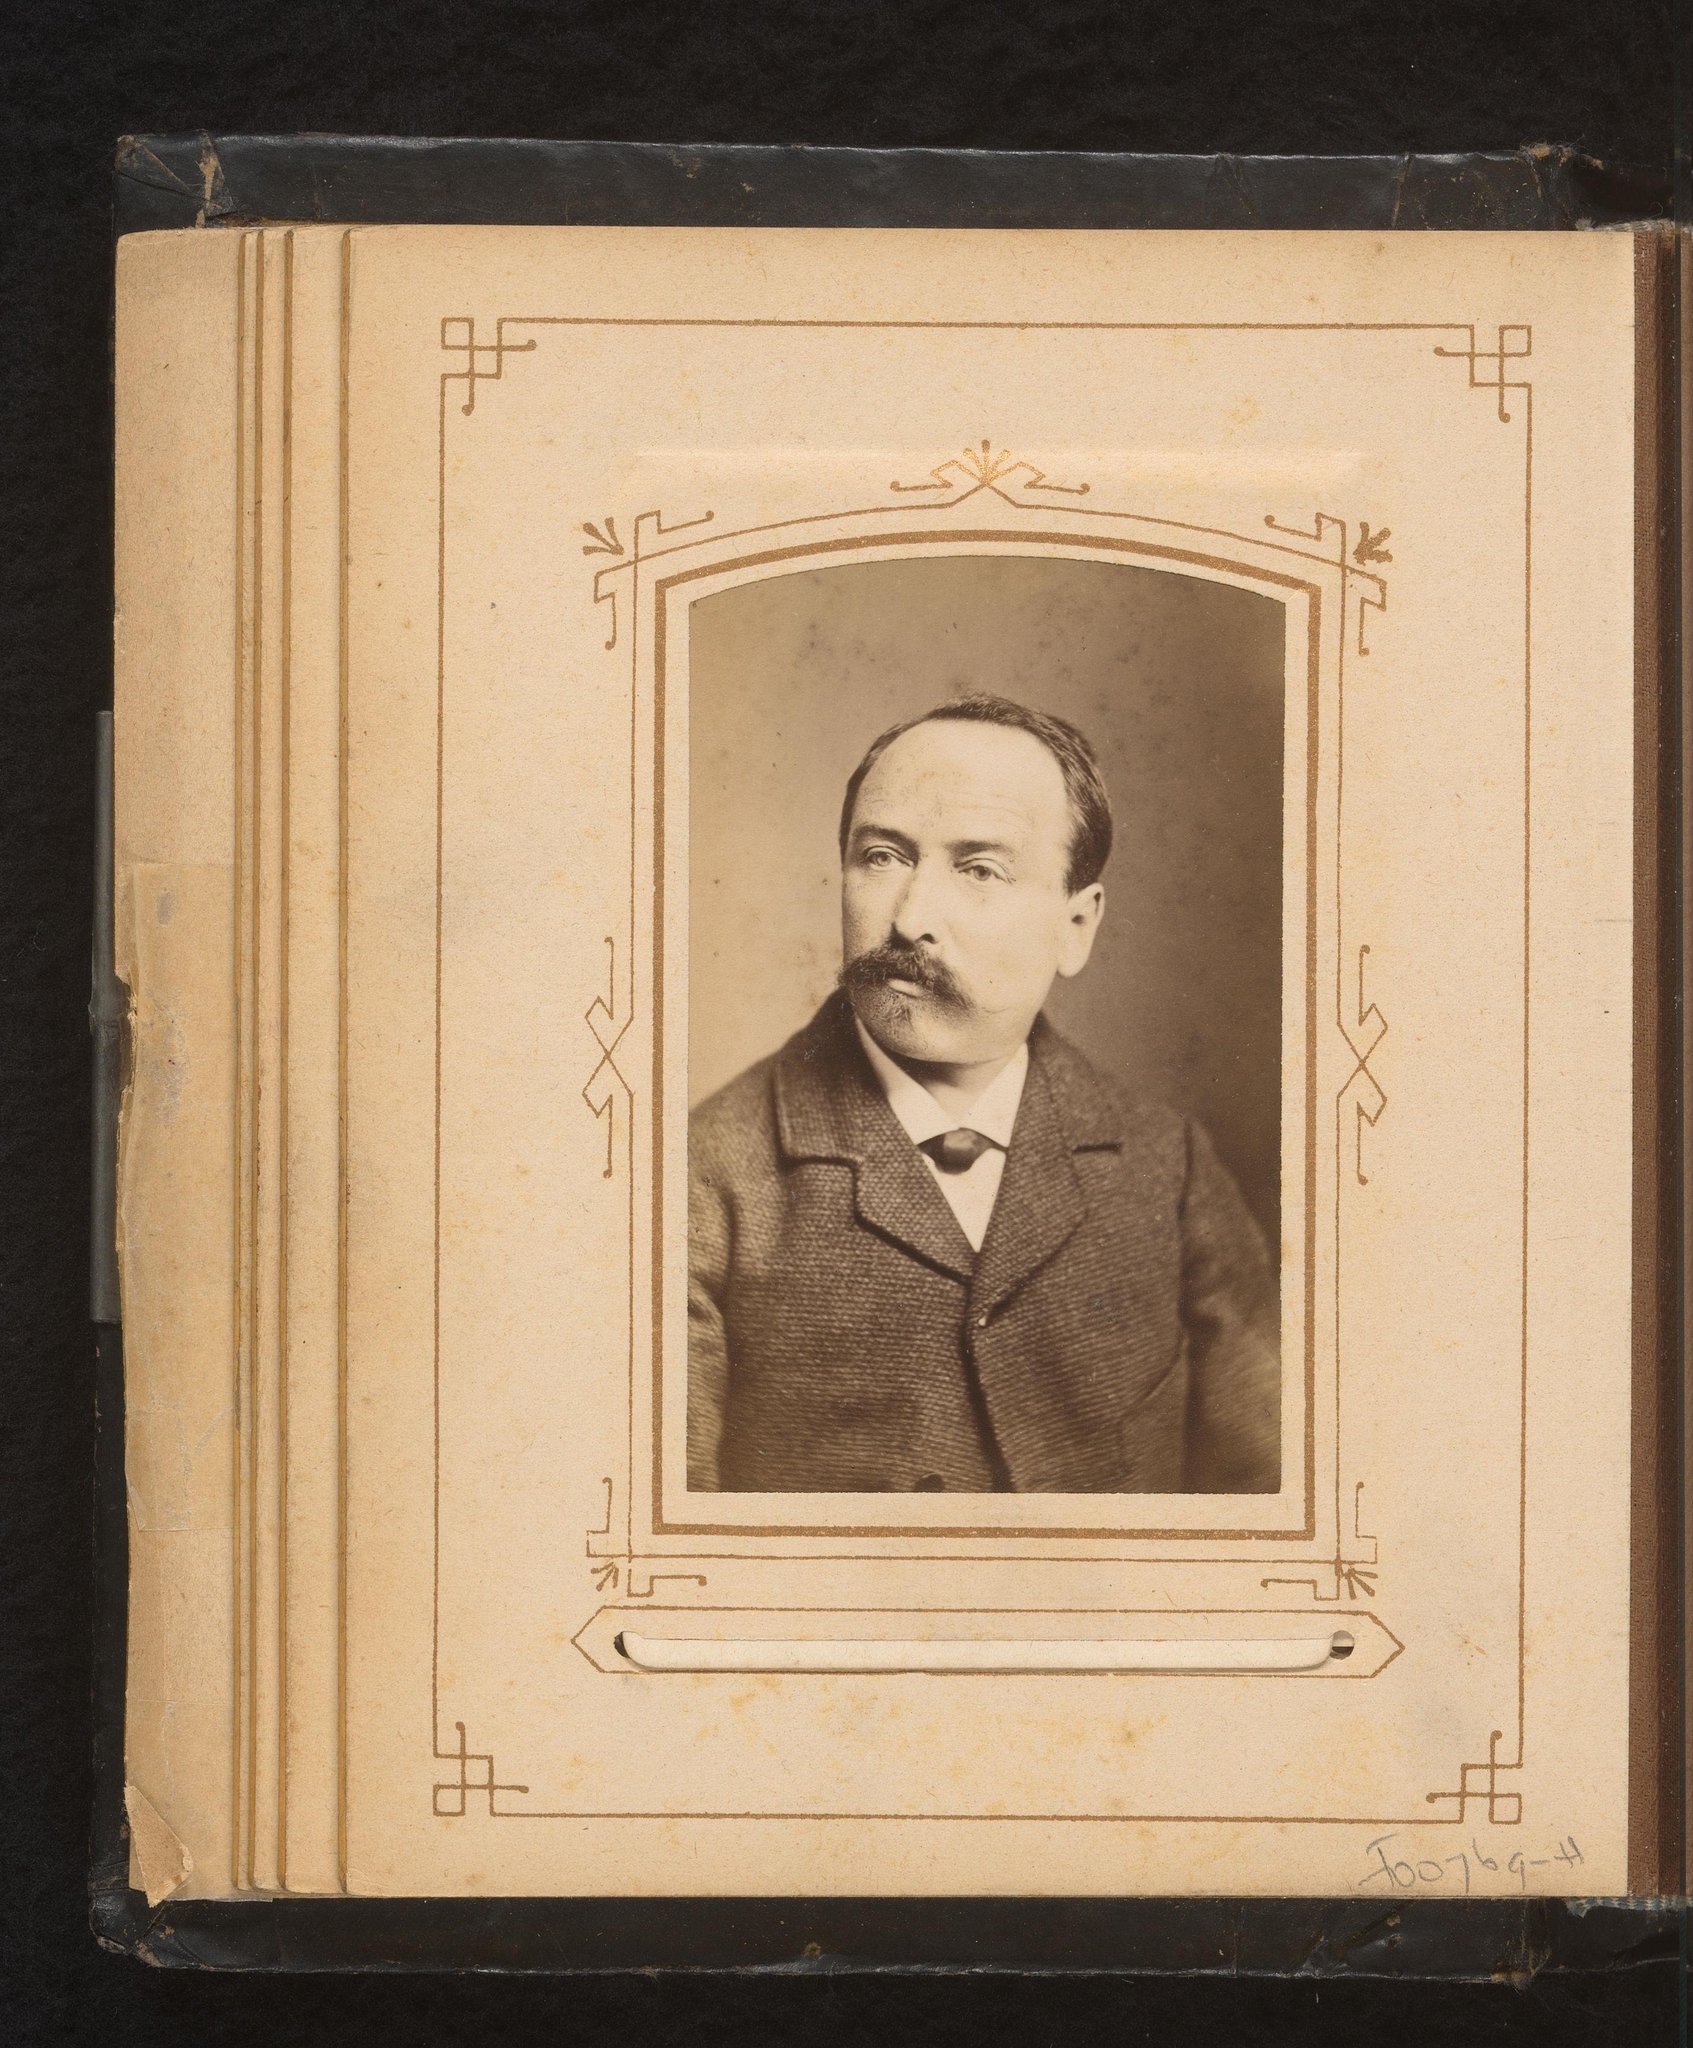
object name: album leaf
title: Portret van een man met snor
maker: robert ruegg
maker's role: fotograaf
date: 1870-1900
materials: cardboard, photographic support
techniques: albumen print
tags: moustache, adult man, historical persons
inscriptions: inscription: ‘Photographie/ Robert Ruegg/ Badstrasse No. 516/ Baden/ Schweiz (...)’